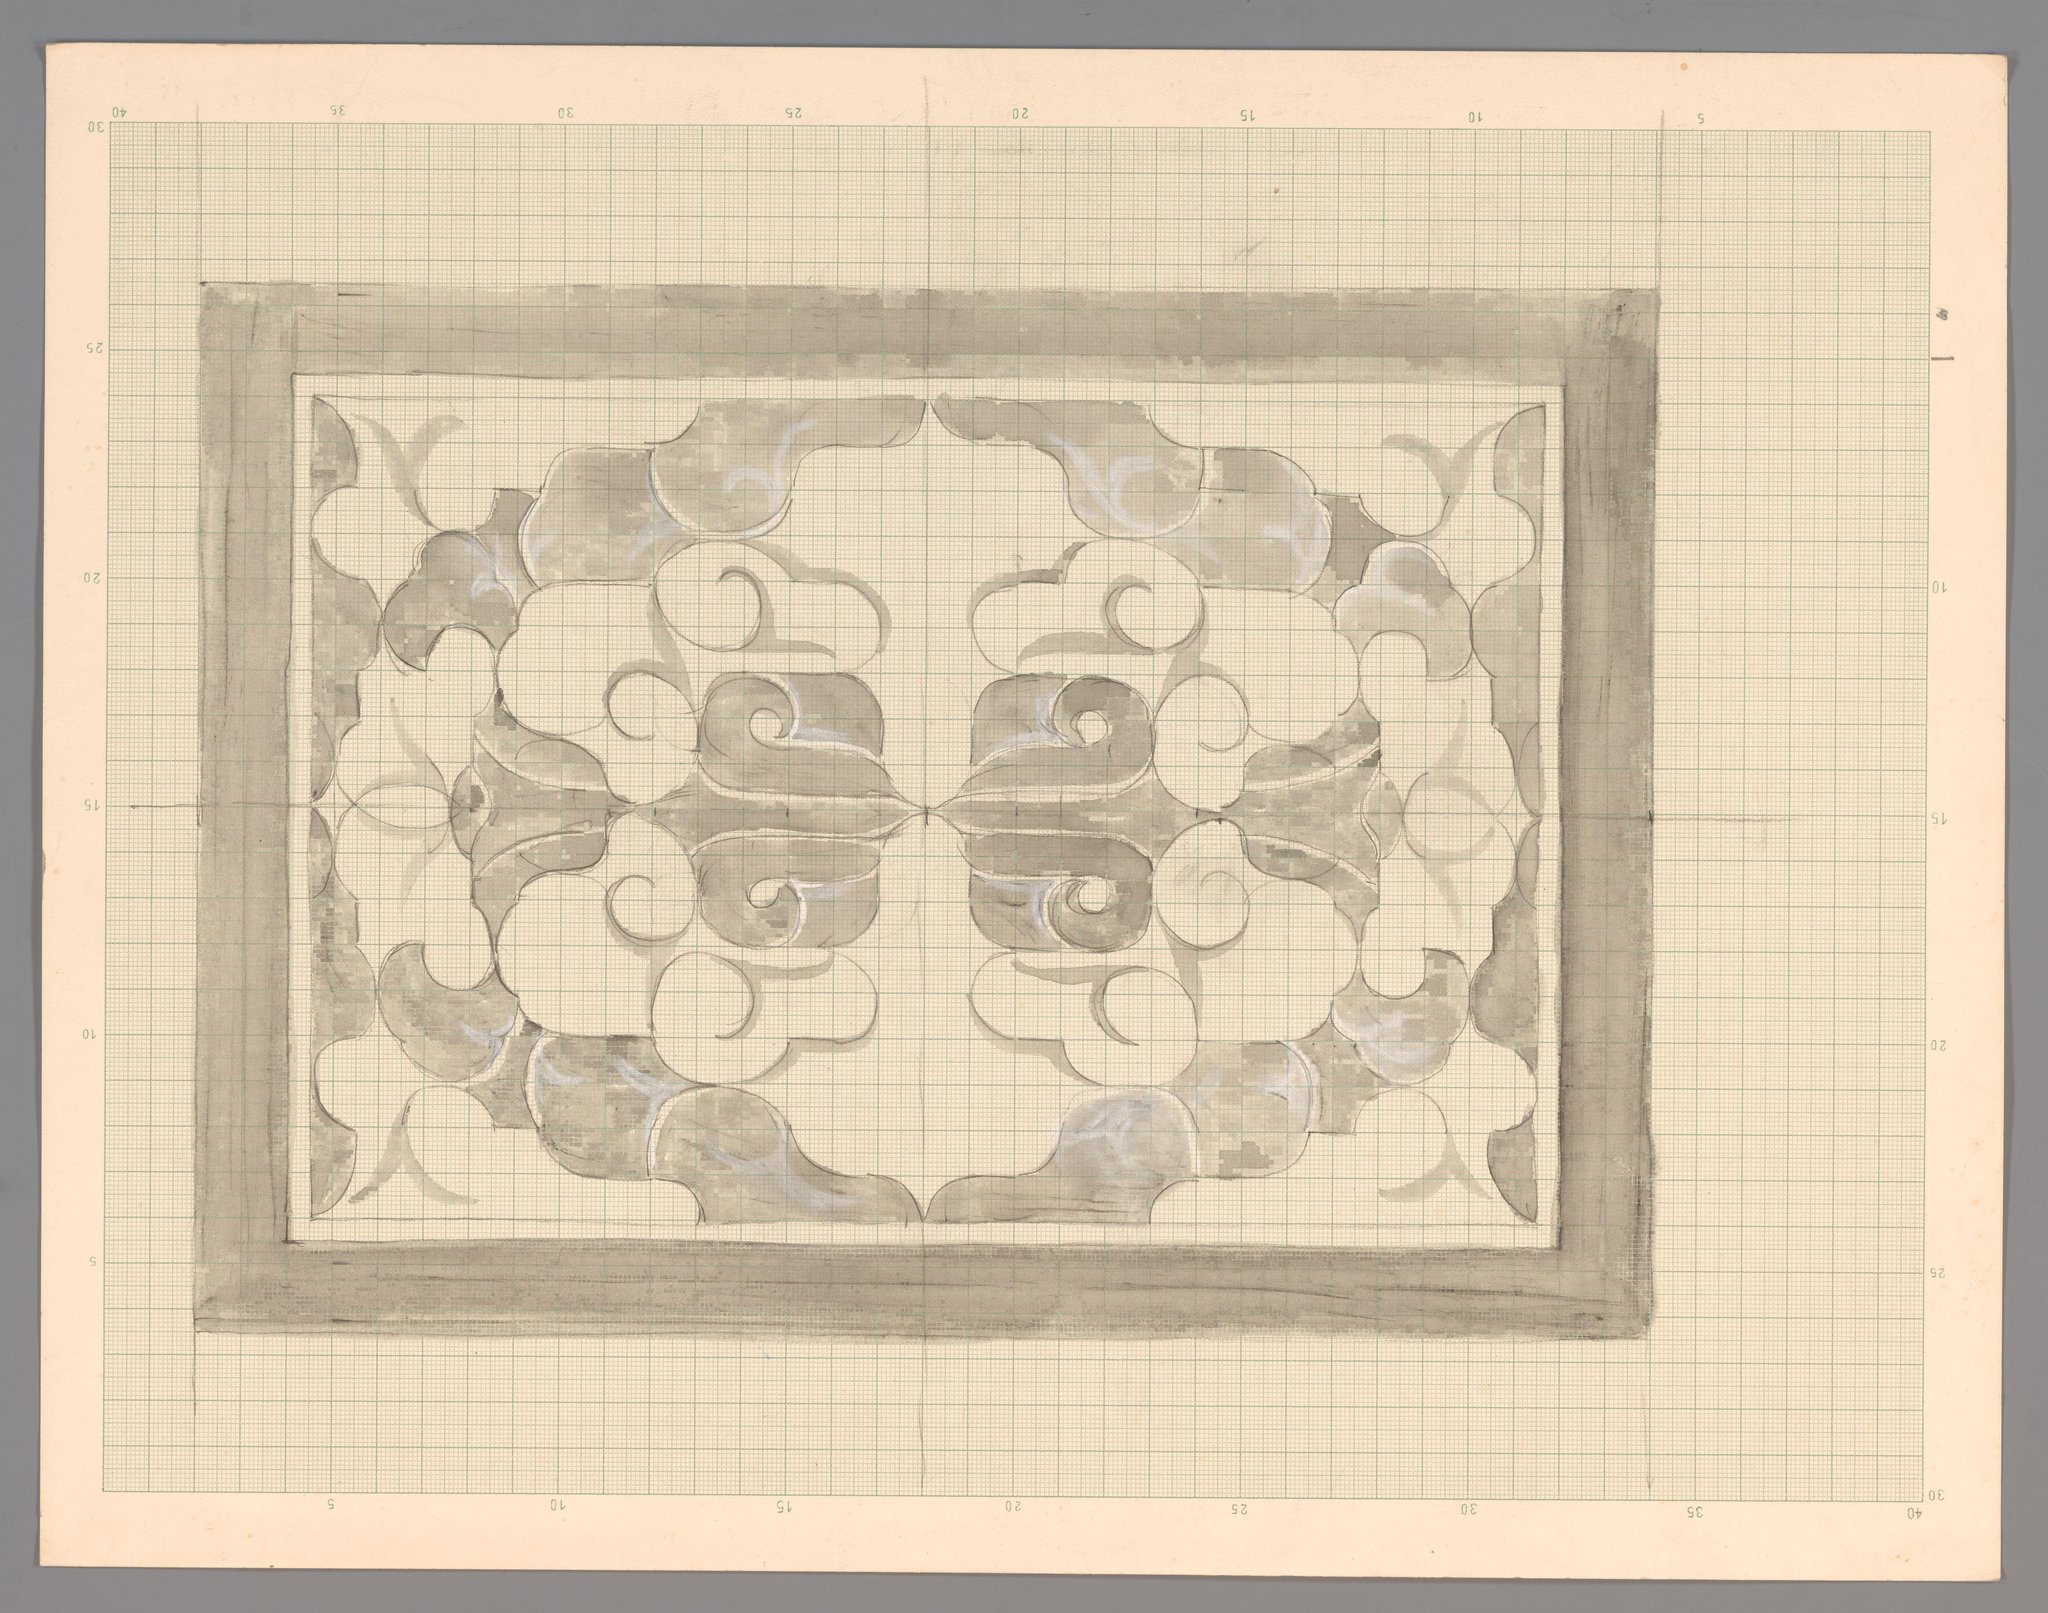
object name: drawing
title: Decoratieontwerp in grijs en wit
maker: carel adolph lion cachet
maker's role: draughtsman, print maker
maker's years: 1864-1945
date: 1874-1945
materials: paint, pencil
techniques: brush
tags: ornaments ~ art